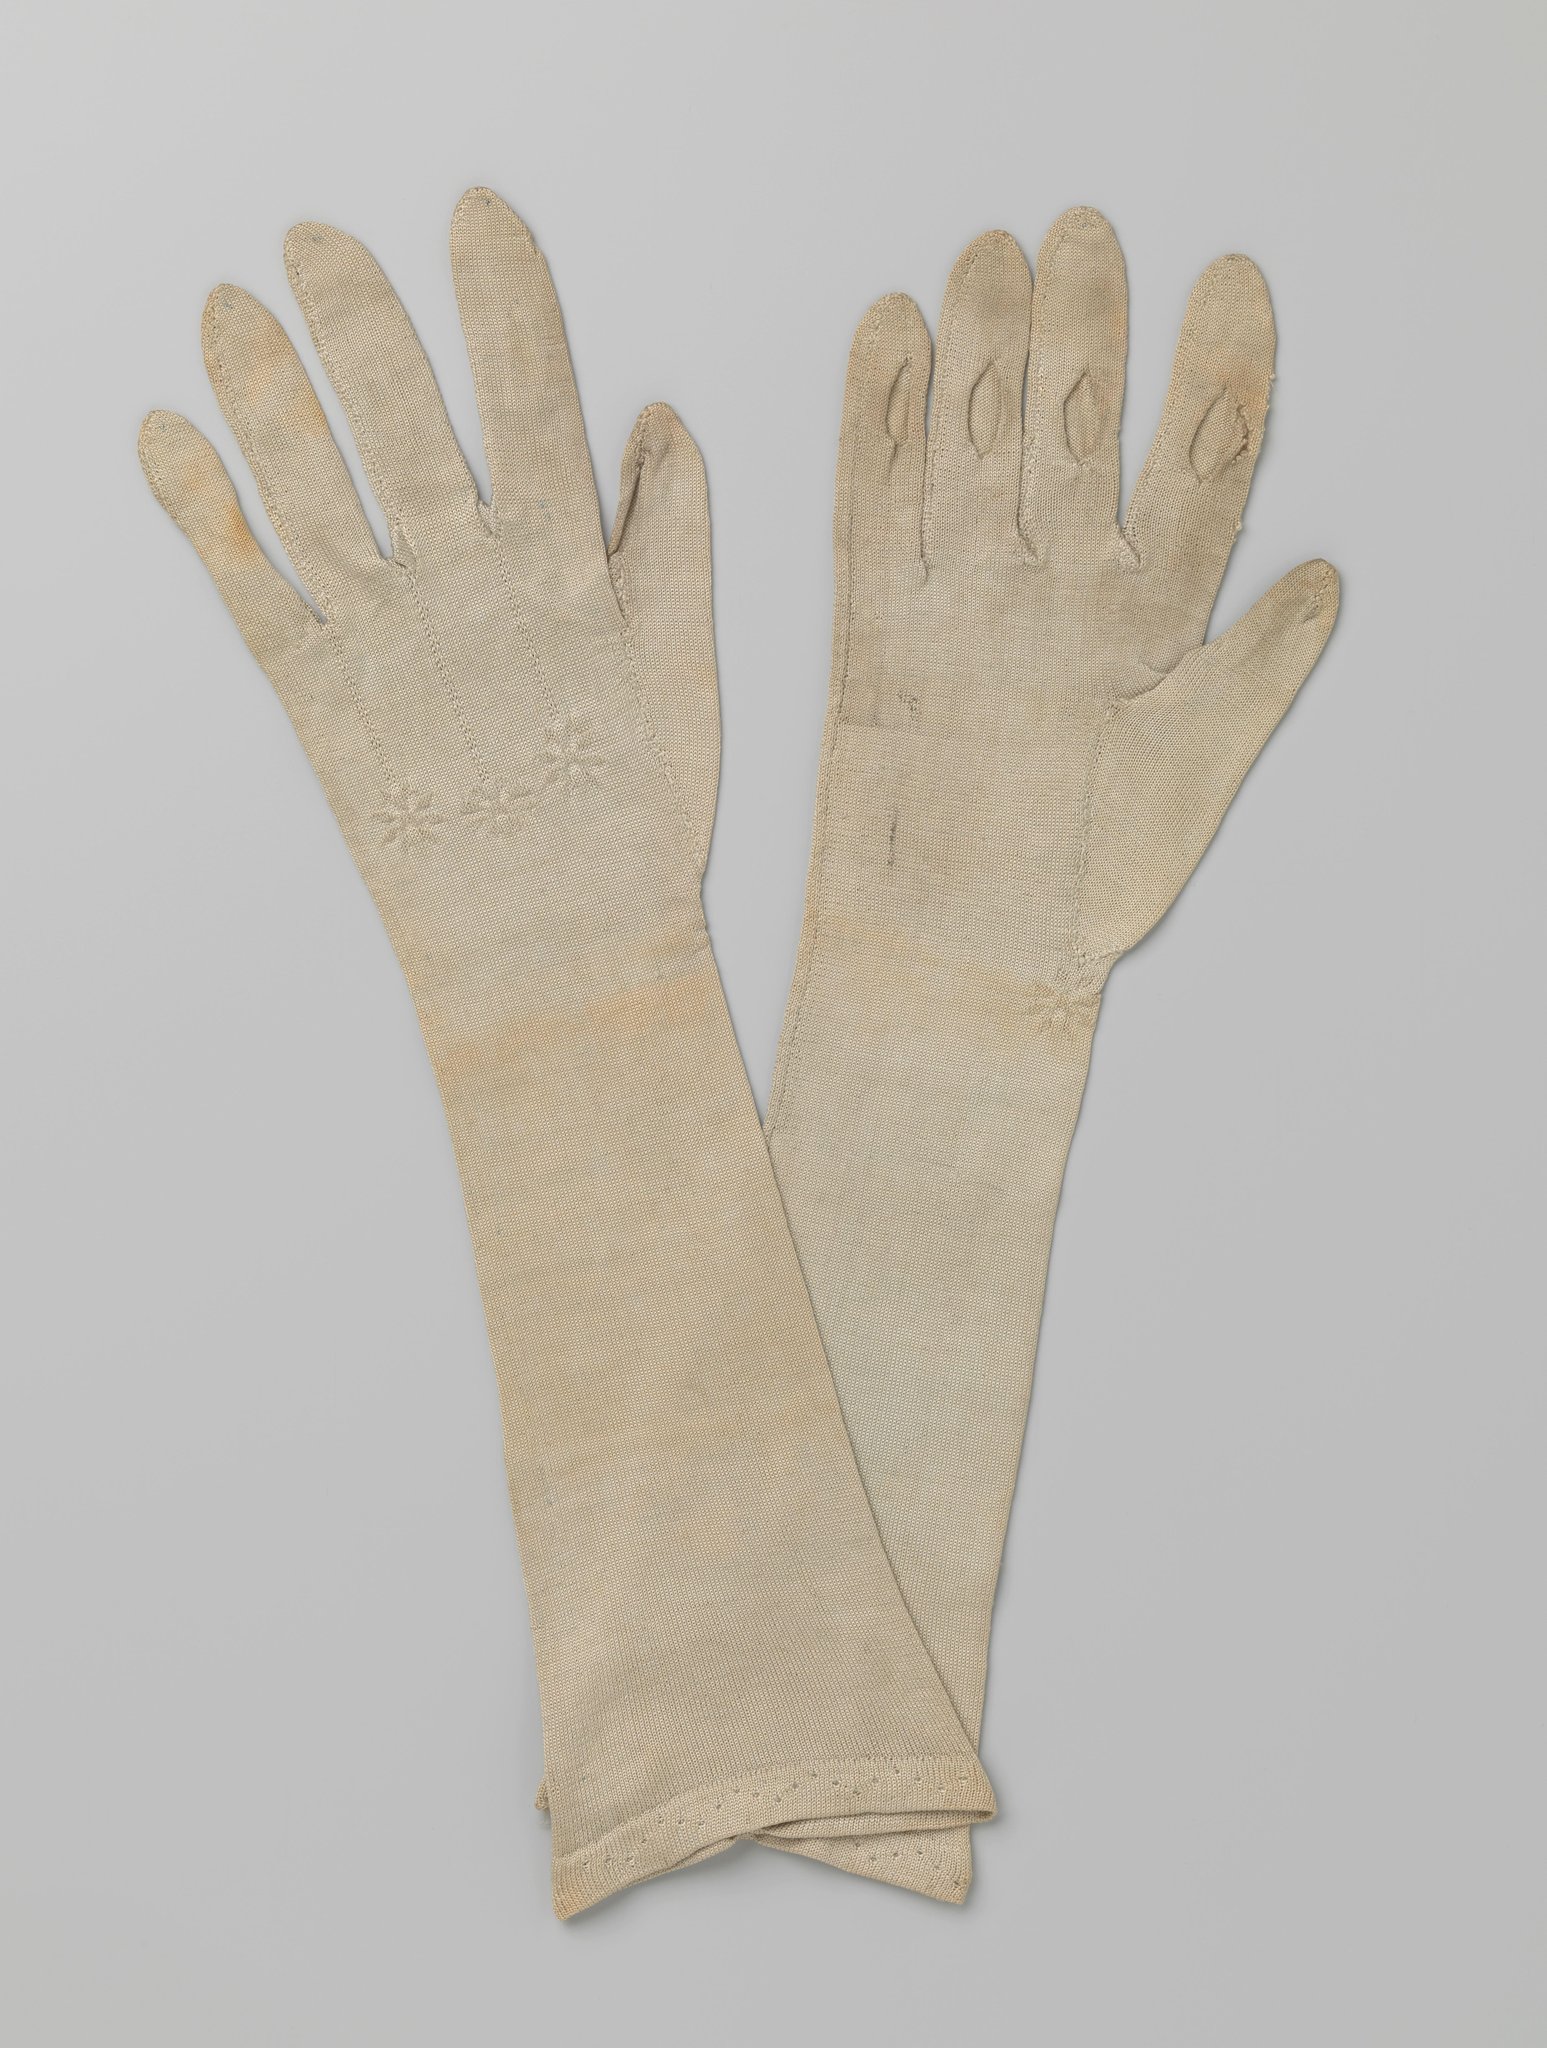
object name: clothing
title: Handschoen van witte gebreide zijde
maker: Anonymous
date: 1800-1850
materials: silk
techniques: knitting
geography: netherlands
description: Linker handschoen van witte zijde, met ovaalvormige openingen aan de binnenzijden van de vingertoppen, op de rug drie uitstralende koorden eindigend in bloemen.